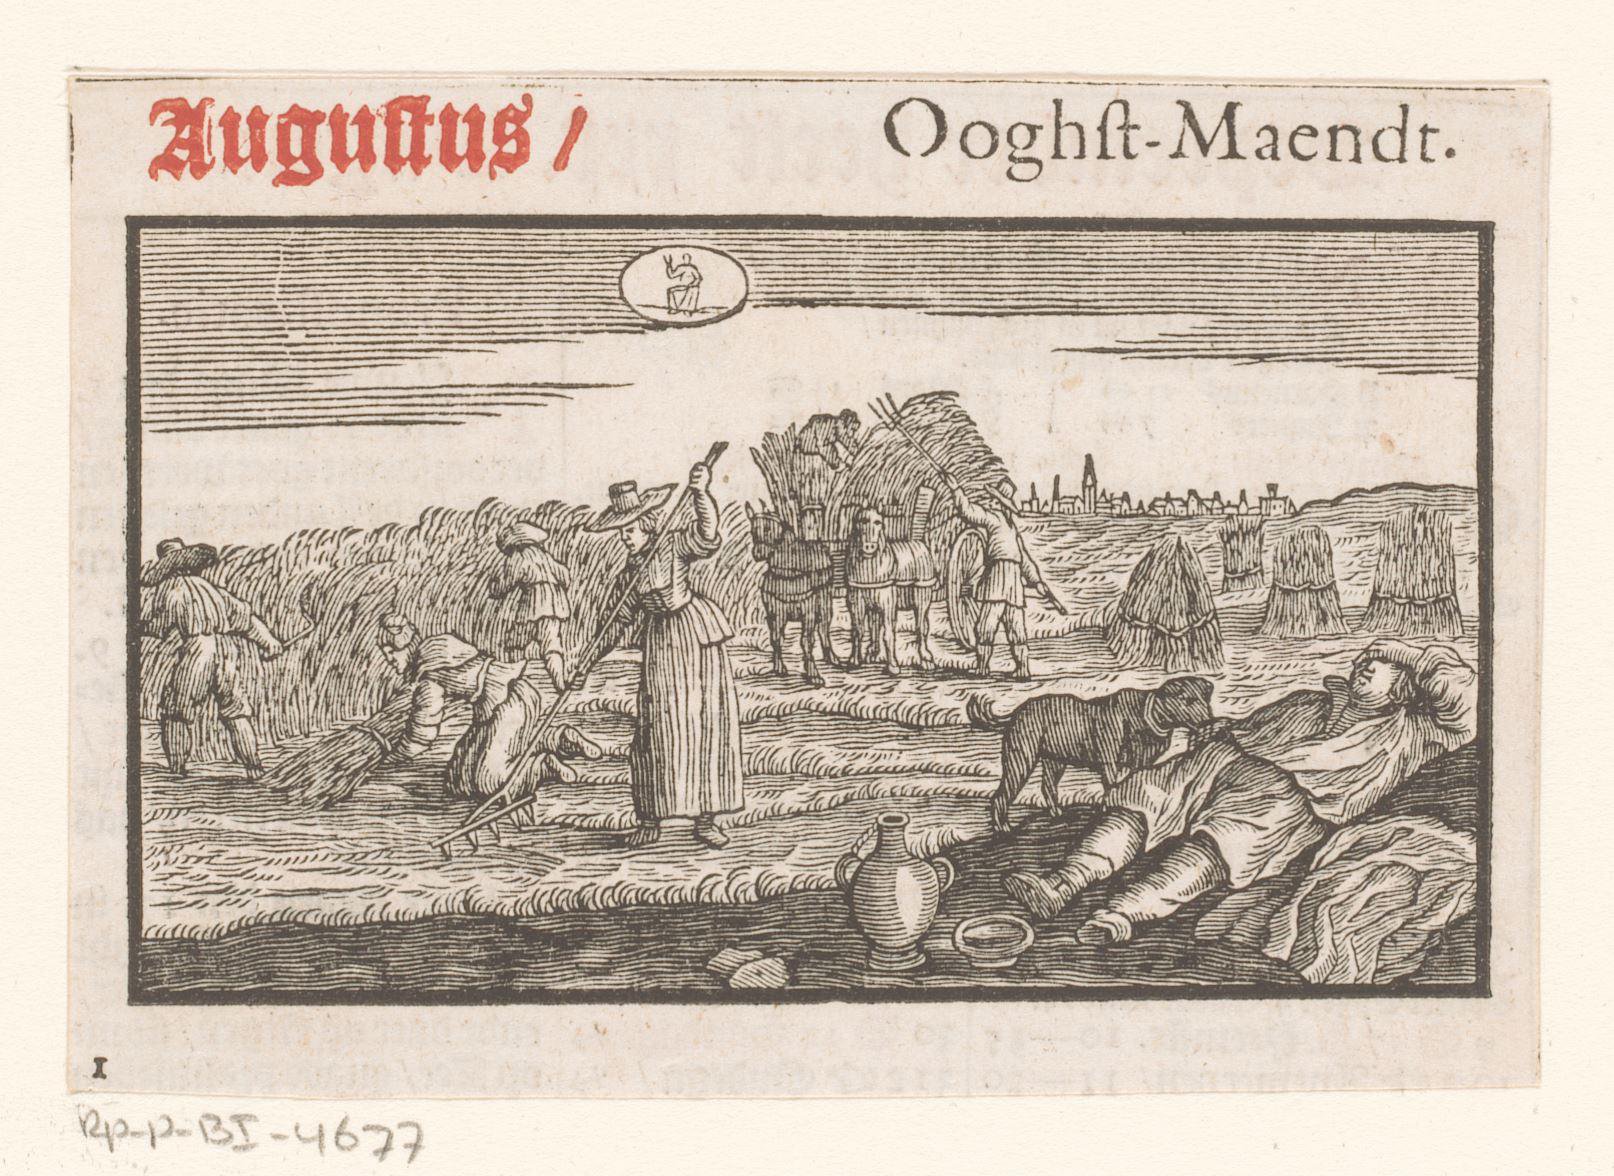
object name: print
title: Augustus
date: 1664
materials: paper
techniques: letterpress printing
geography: amsterdam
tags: harvest, august and its 'labours' (+ with virgo (august))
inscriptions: collector's mark: Lugt 240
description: Zes figuren zijn gewas aan het oogsten en laden een hooiwagen vol met hooi. Rechts ligt een man in het gras. Middenboven een maagd.